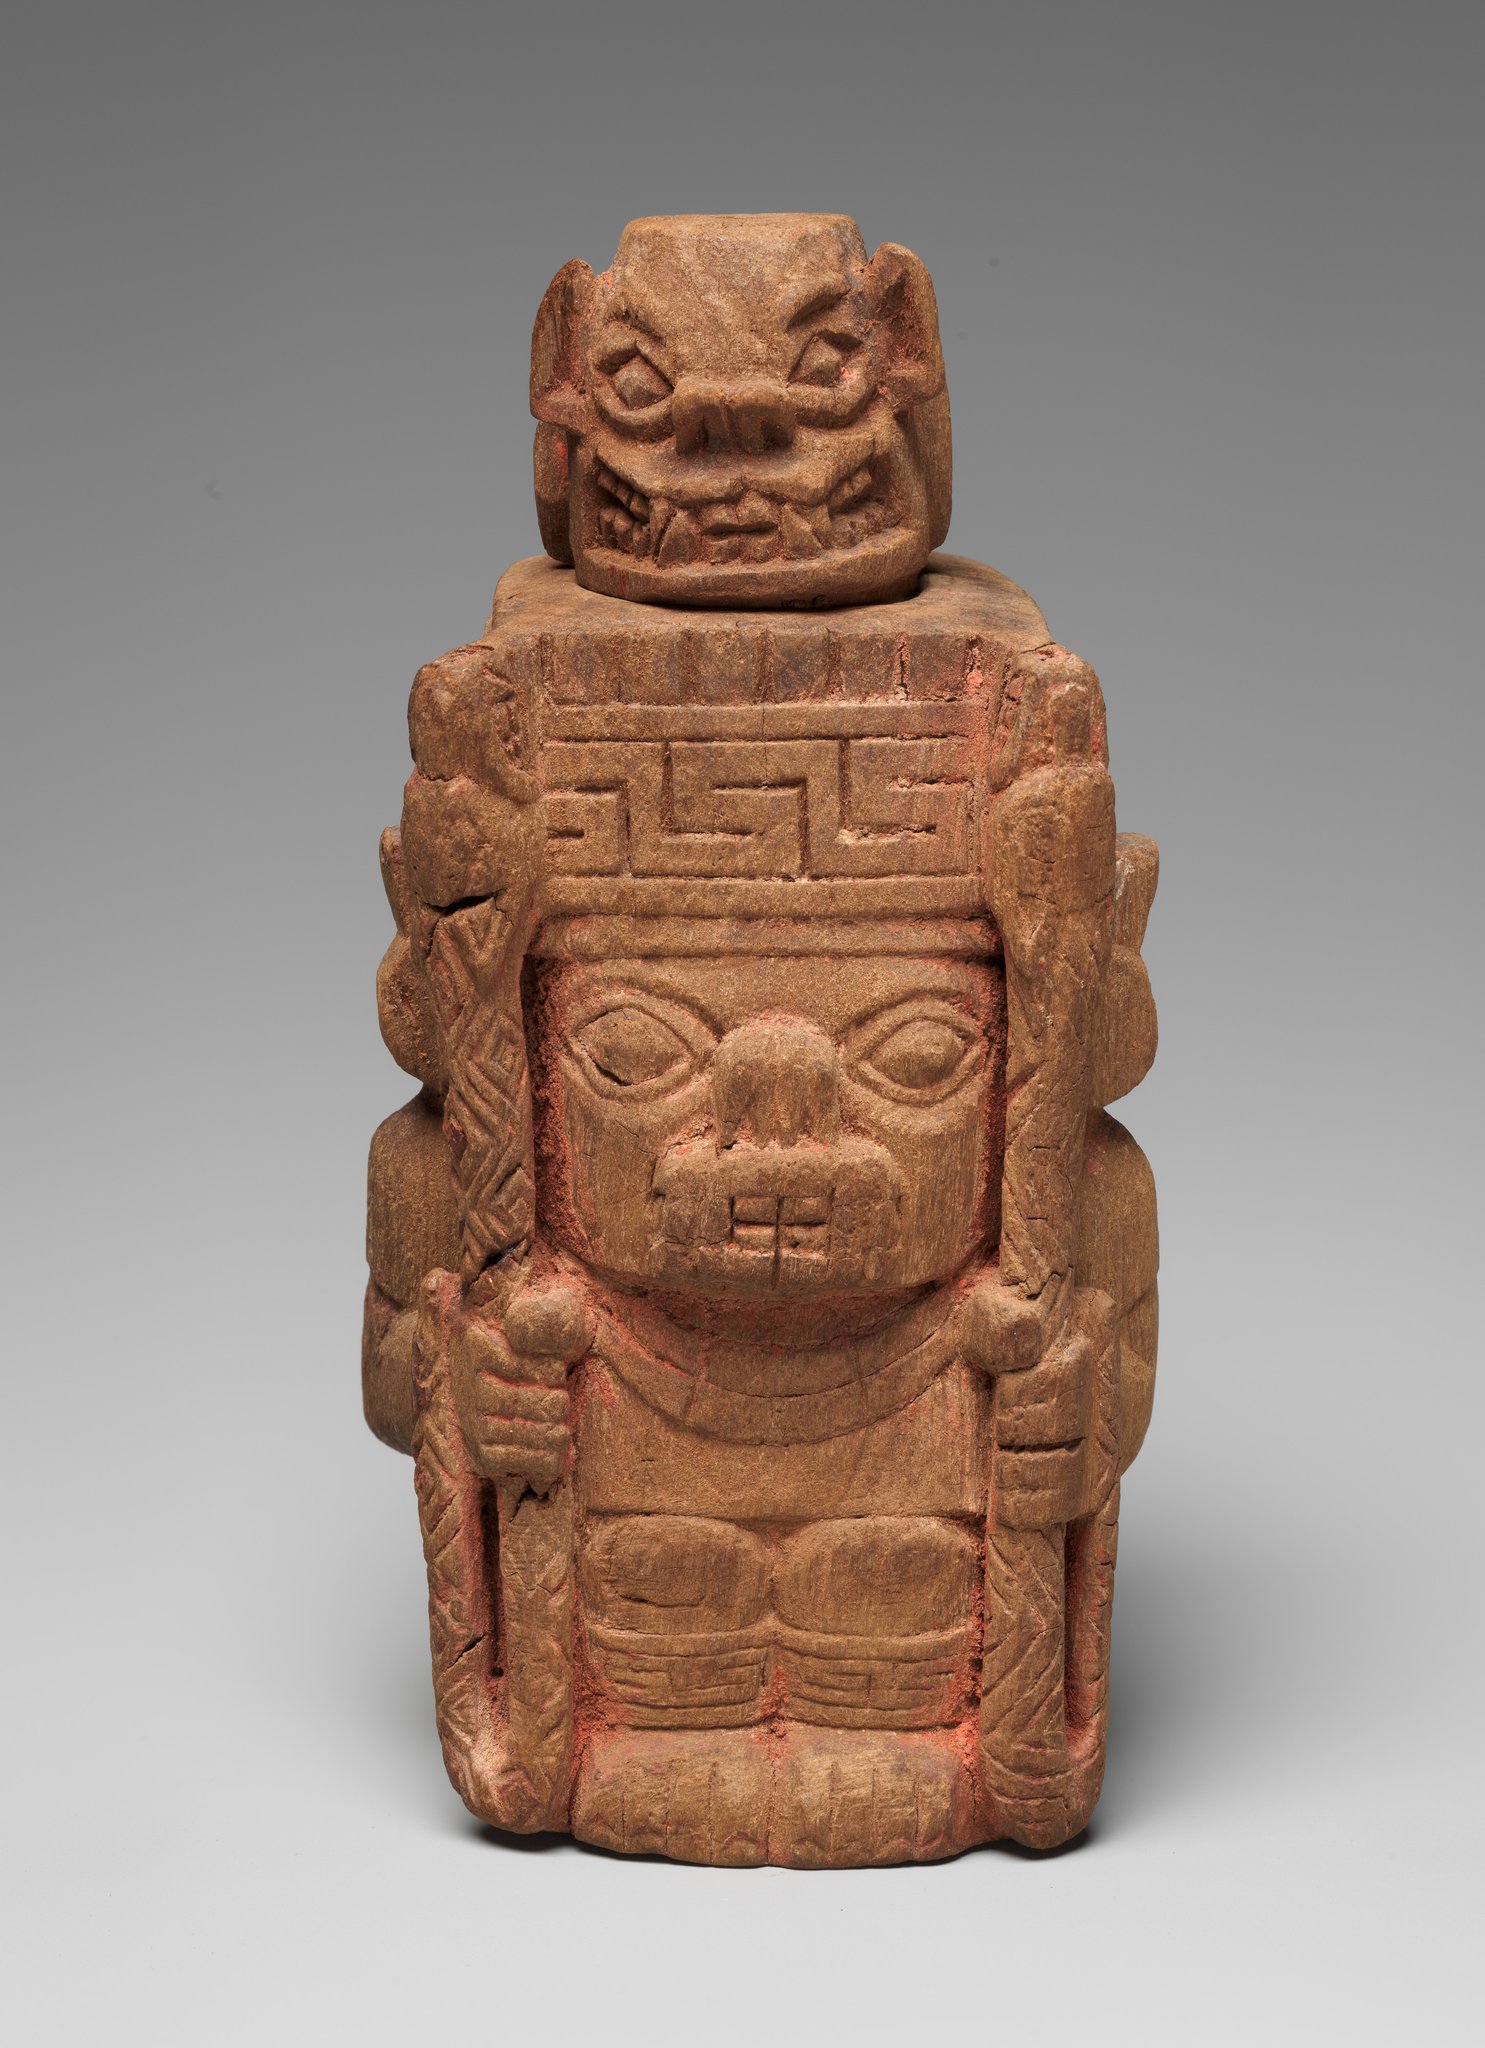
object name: lime container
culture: wari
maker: wari artist(s)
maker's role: artist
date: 650-1000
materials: pigment, wood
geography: peru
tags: weapons,men